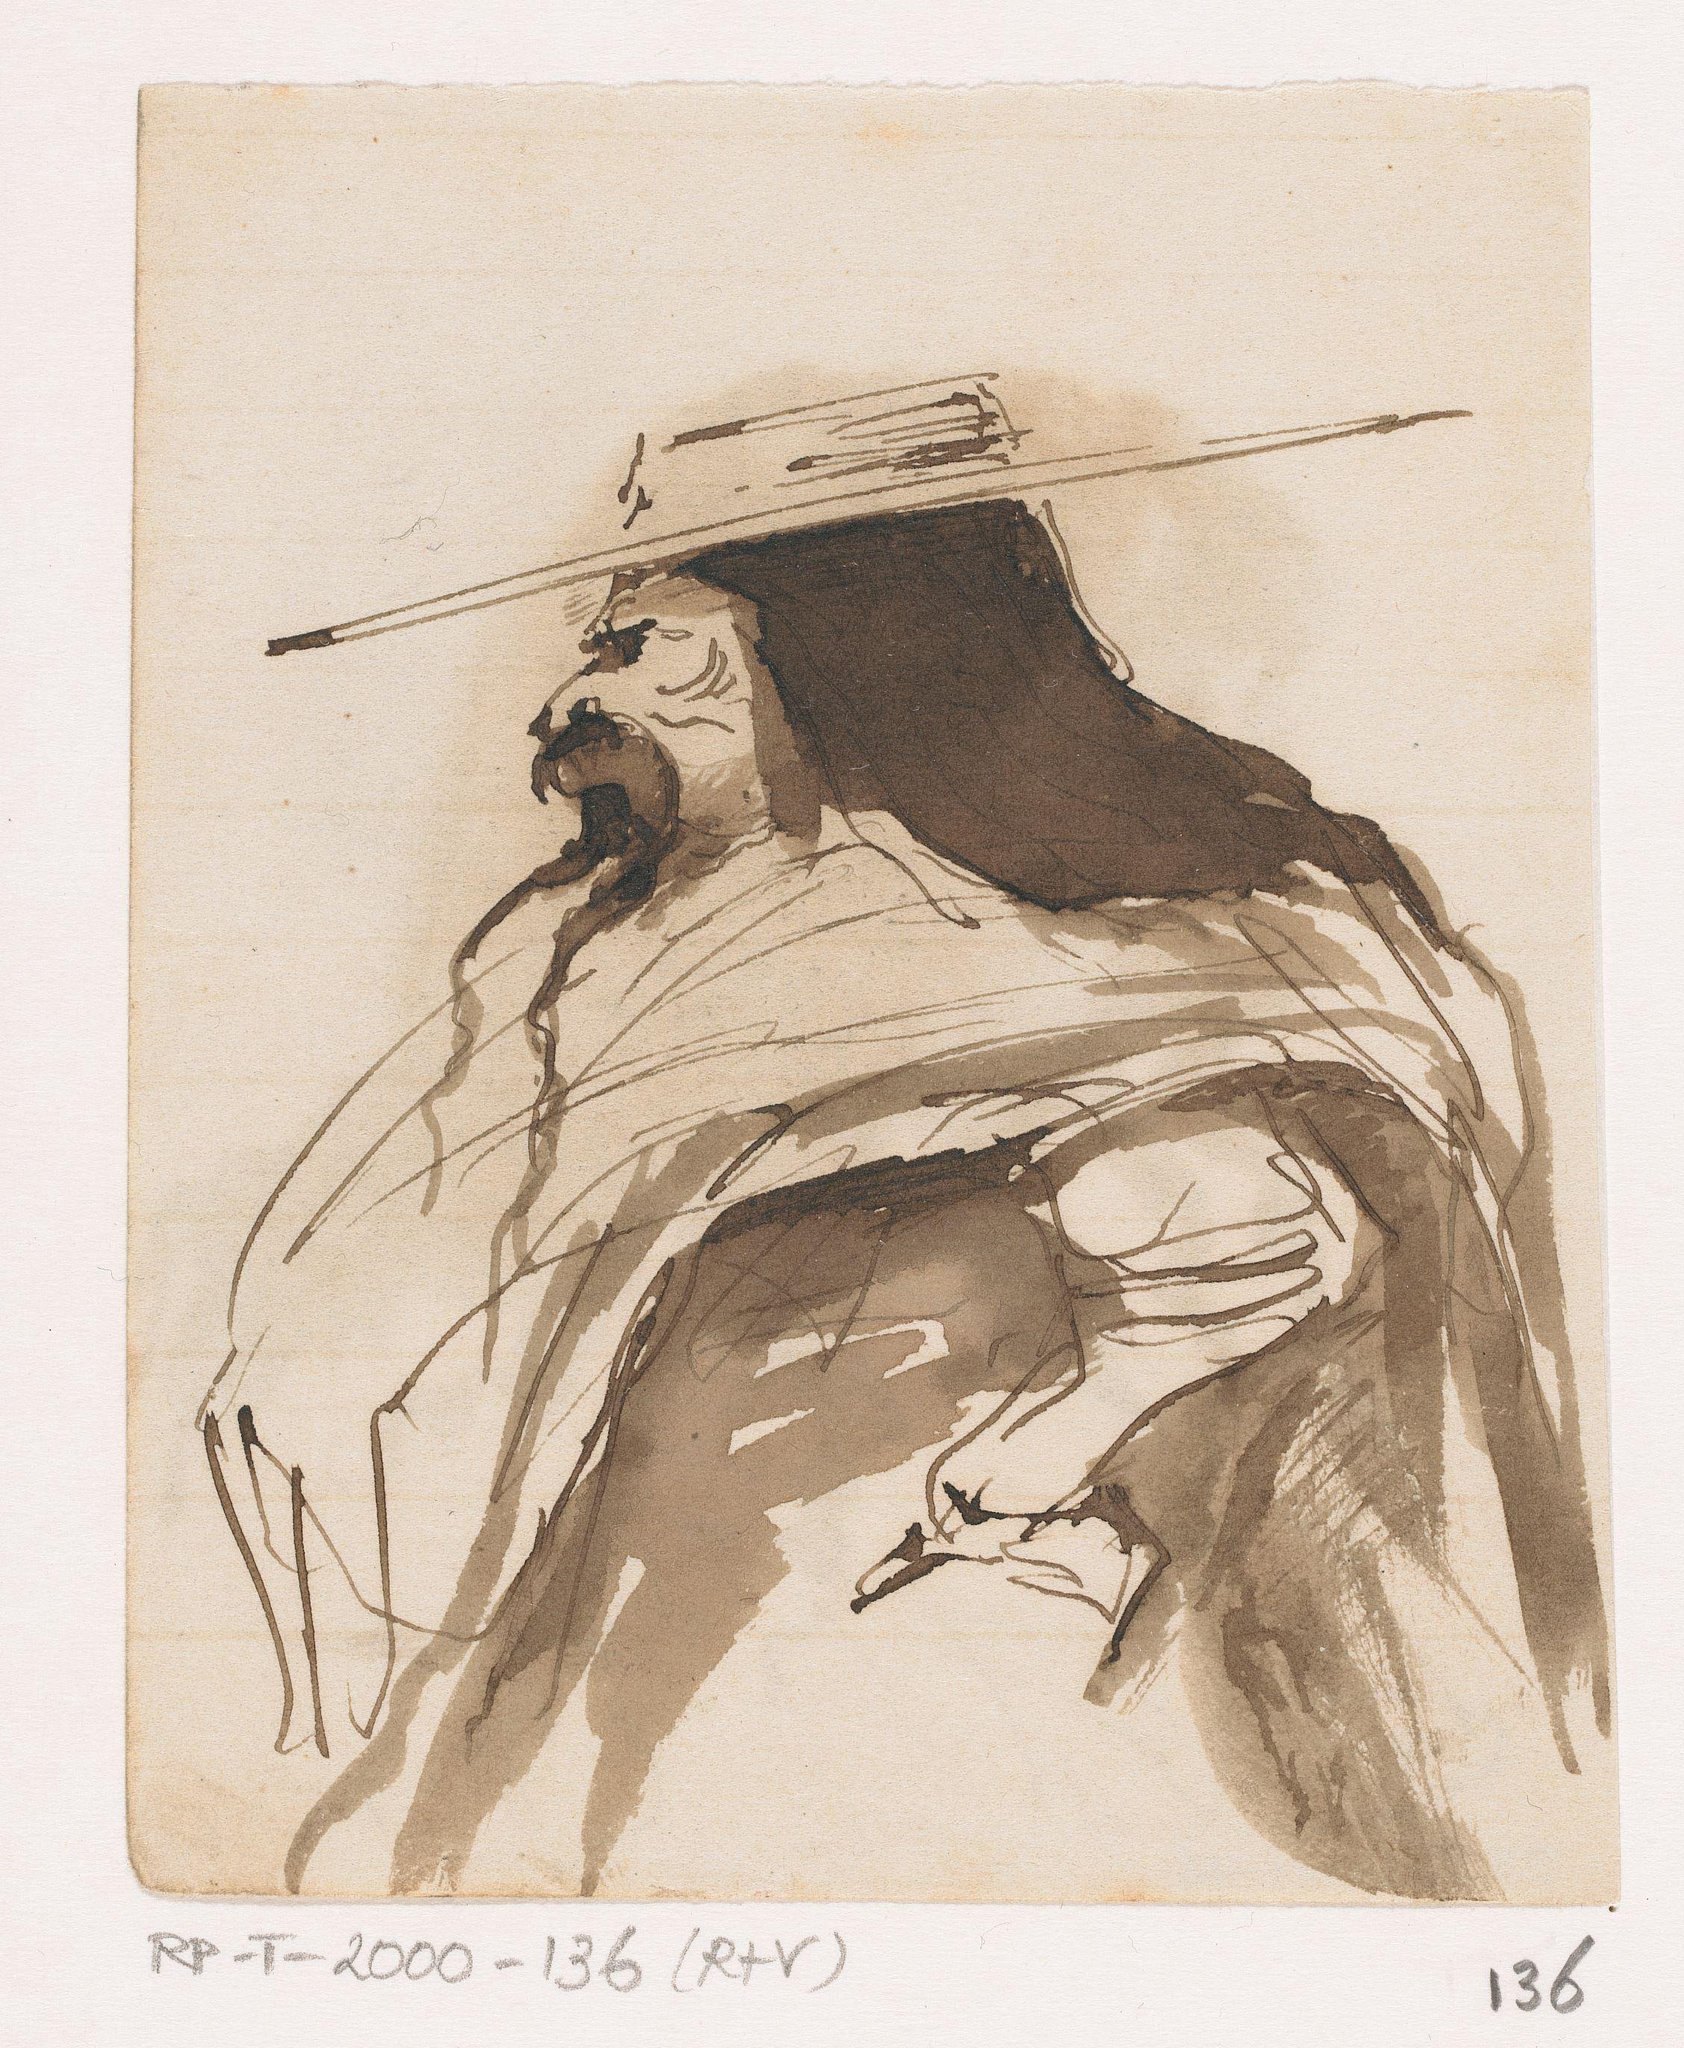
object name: drawing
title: Slavoniër en profil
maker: johannes tavenraat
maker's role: draughtsman, painter, print maker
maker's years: 1809-1881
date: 1807-1858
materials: ink, paper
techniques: brush, pen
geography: bohemia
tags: europeans (czechs), moustache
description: Portret van een man met lange snor en hoed met brede rand. Een inwoner van Bohemen, een Slowaak of een Slavoniër.